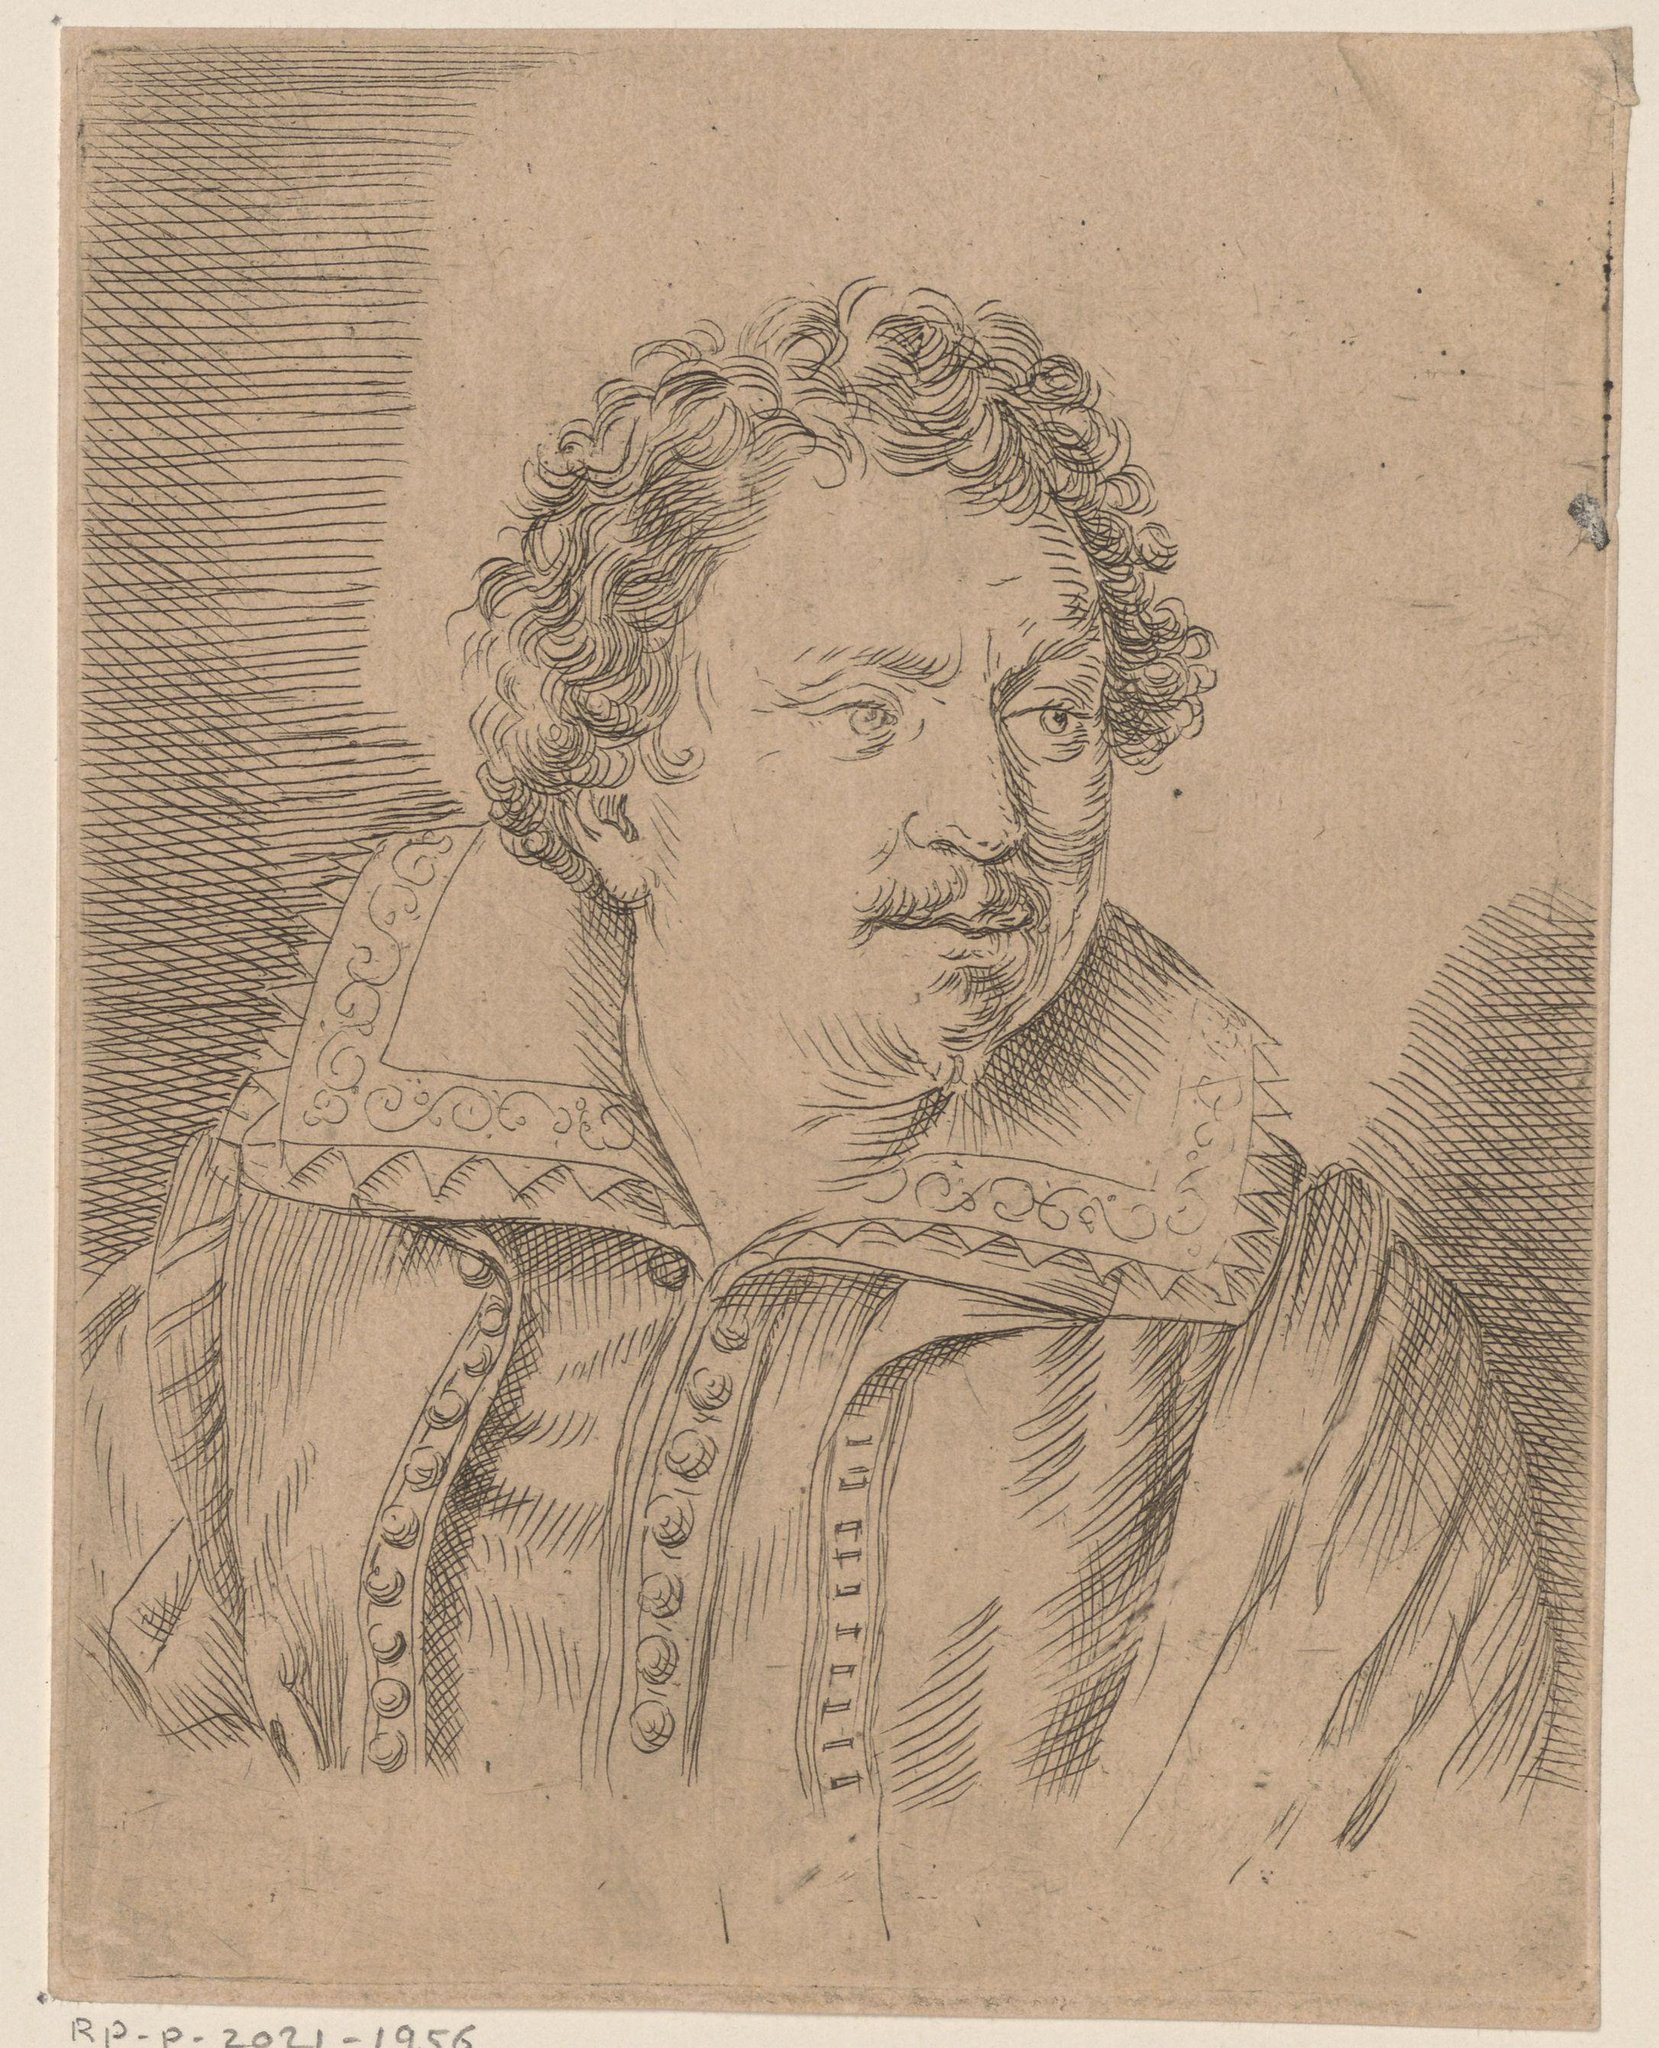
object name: print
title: Portret van een man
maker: Anonymous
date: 1650-1749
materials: paper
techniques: etching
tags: historical persons not known by name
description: Op het opzetvel aangeduid als Joseph Heintz.